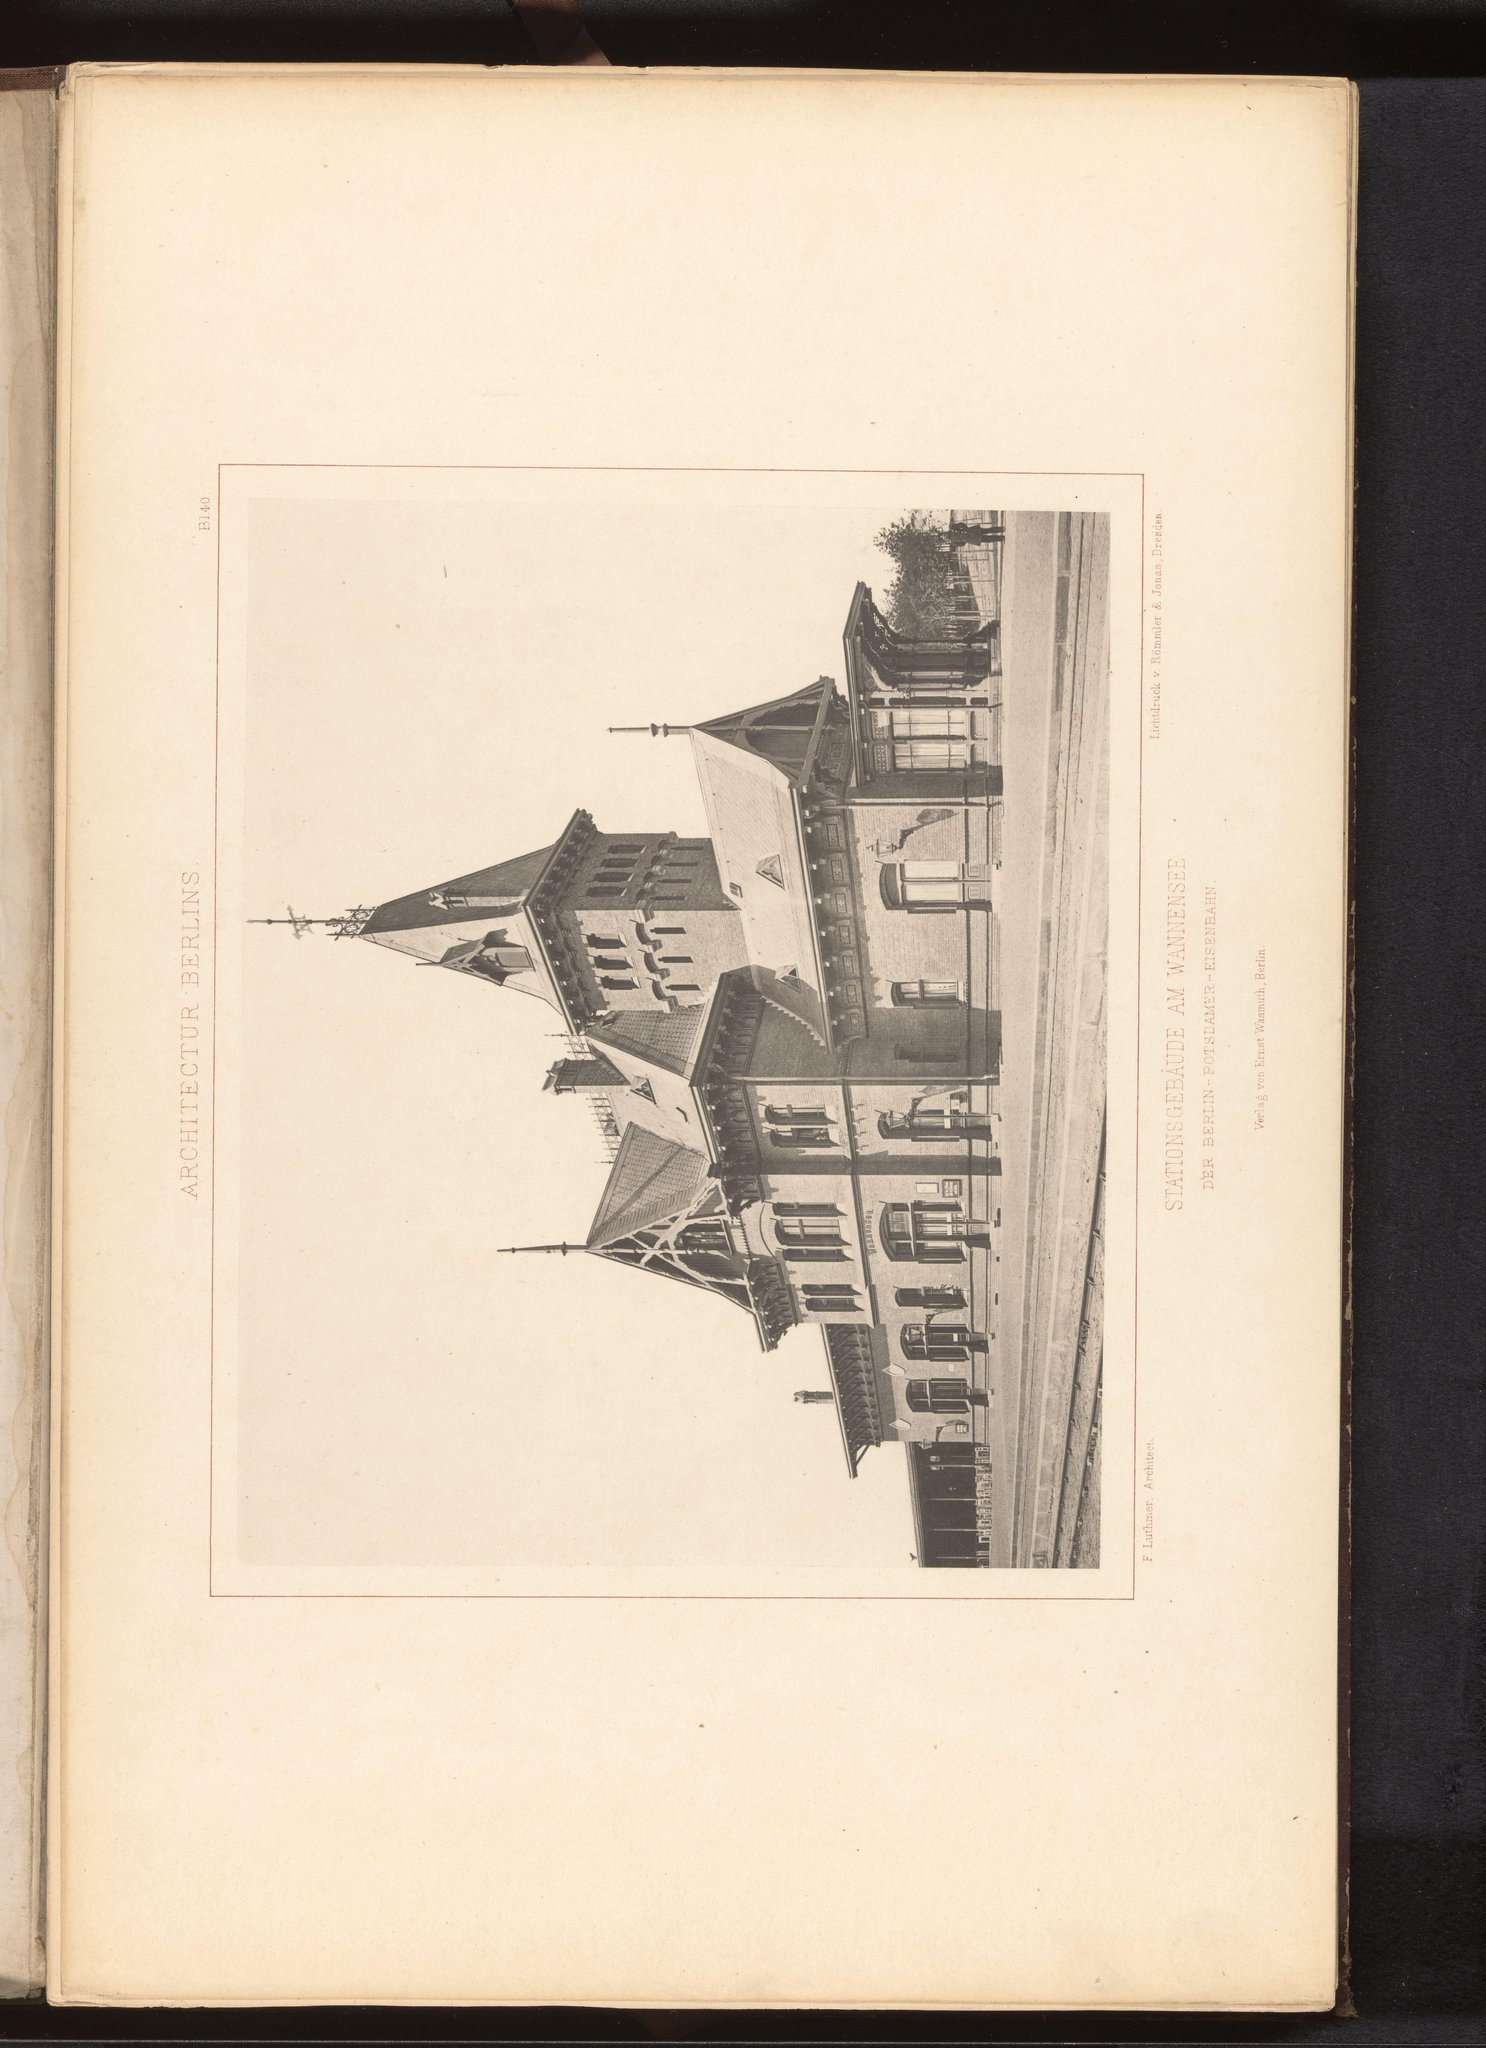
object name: photomechanical print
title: Gezicht op het stationsgebouw het stadsdeel Wannsee in Berlijn, Duitsland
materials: paper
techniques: photograph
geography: berlin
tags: station; shelter (railway, tramway)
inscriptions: inscription: ‘F. Luthmer, Architect.’, number: ‘Bl. 40.’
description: Deze prent maakt deel uit van een omslag met honderd prenten en zes tekstbladen.